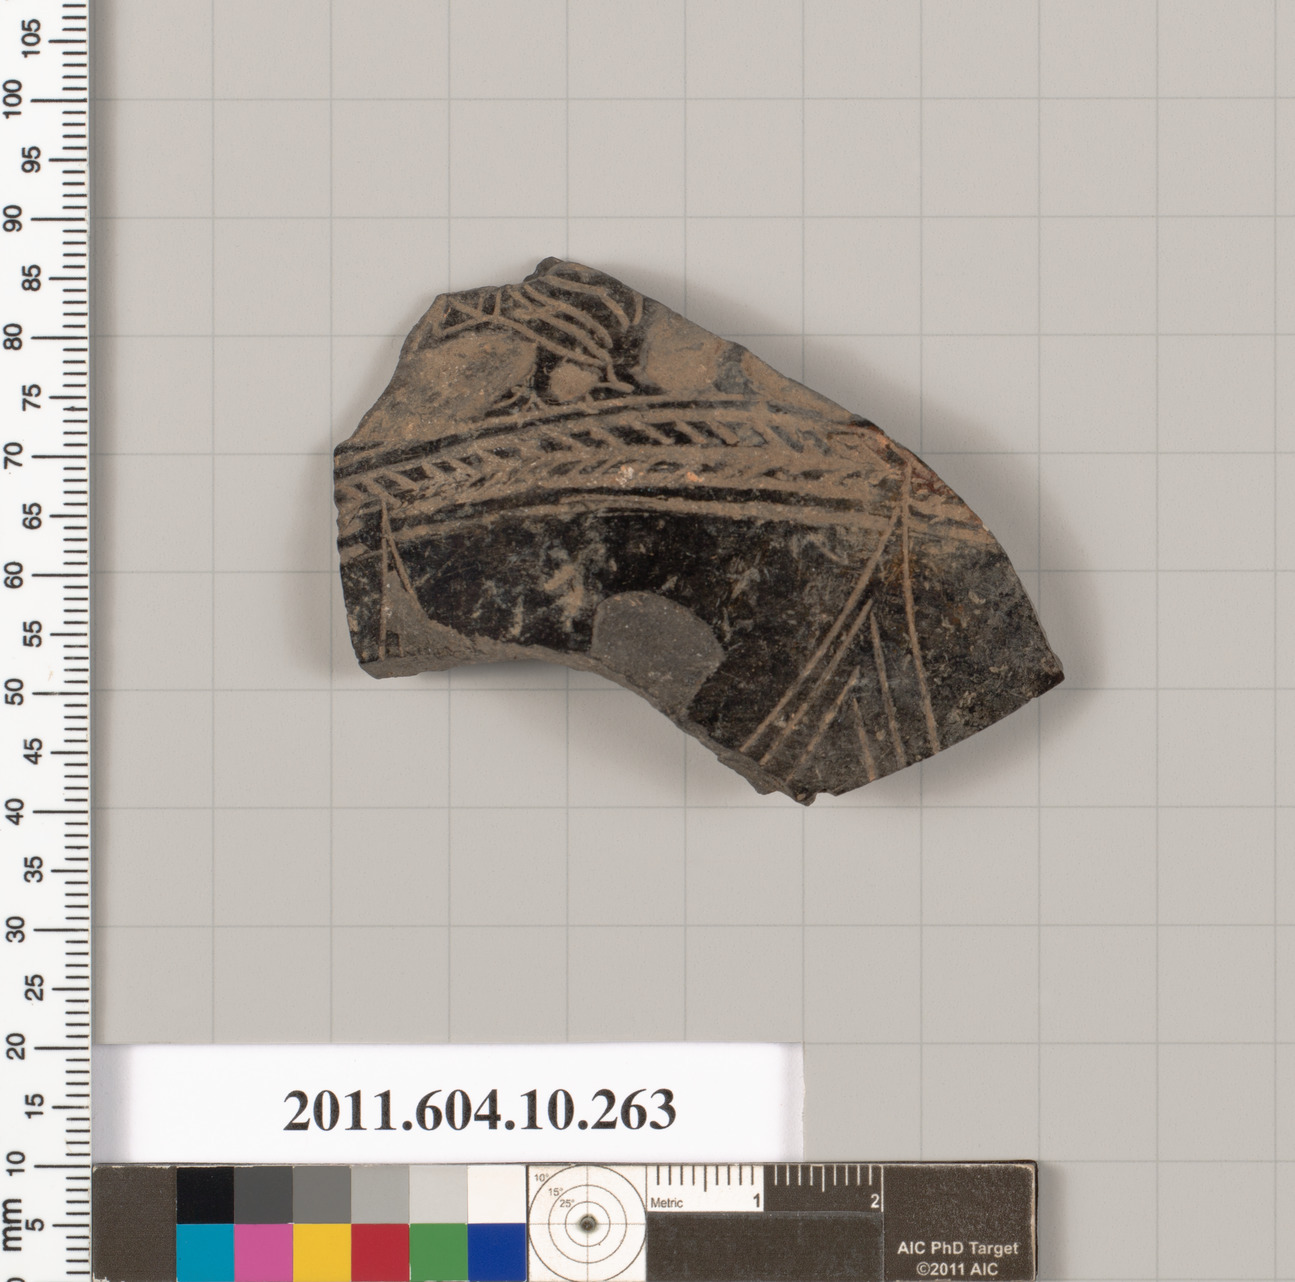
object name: undetermined open shape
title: Terracotta fragment of an open shape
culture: etruscan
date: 600-501 BCE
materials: terracotta